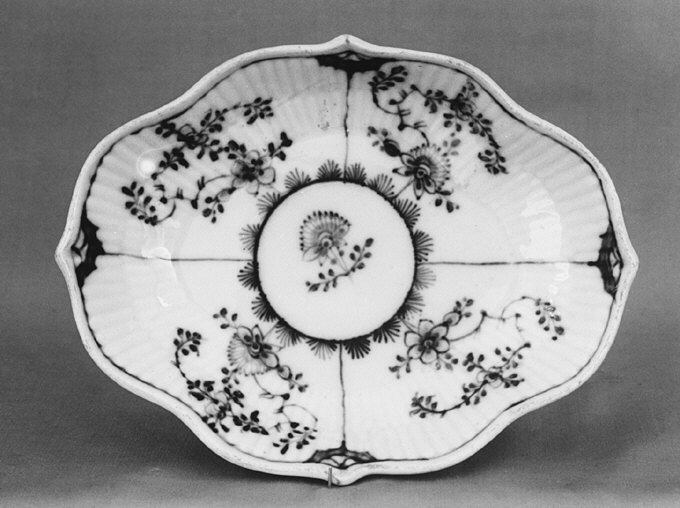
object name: tray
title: Tray (part of a set)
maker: meissen manufactory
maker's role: manufactory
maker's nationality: german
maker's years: 1710-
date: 1740-1750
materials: hard paste porcelain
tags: flowers